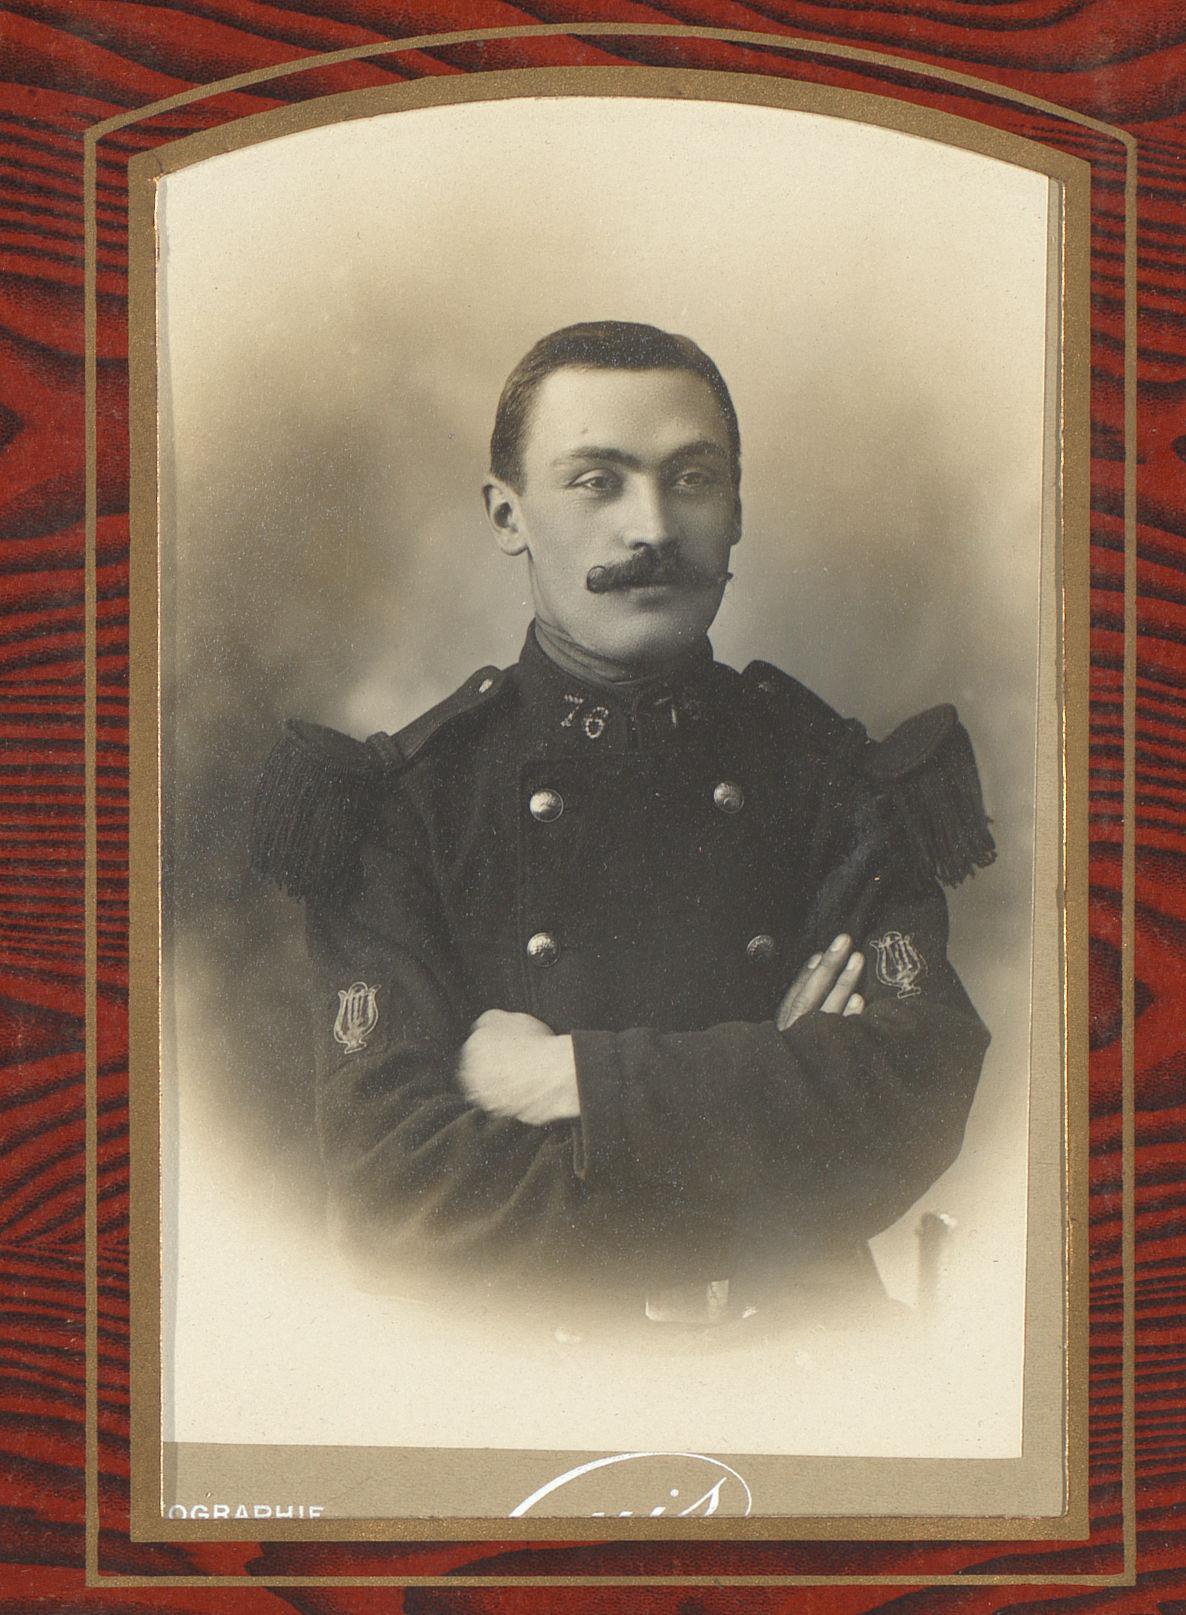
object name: cabinet photograph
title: Portret van een man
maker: louis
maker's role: fotograaf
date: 1860-1920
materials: cardboard, photographic support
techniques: gelatin silver print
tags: adult man, historical persons